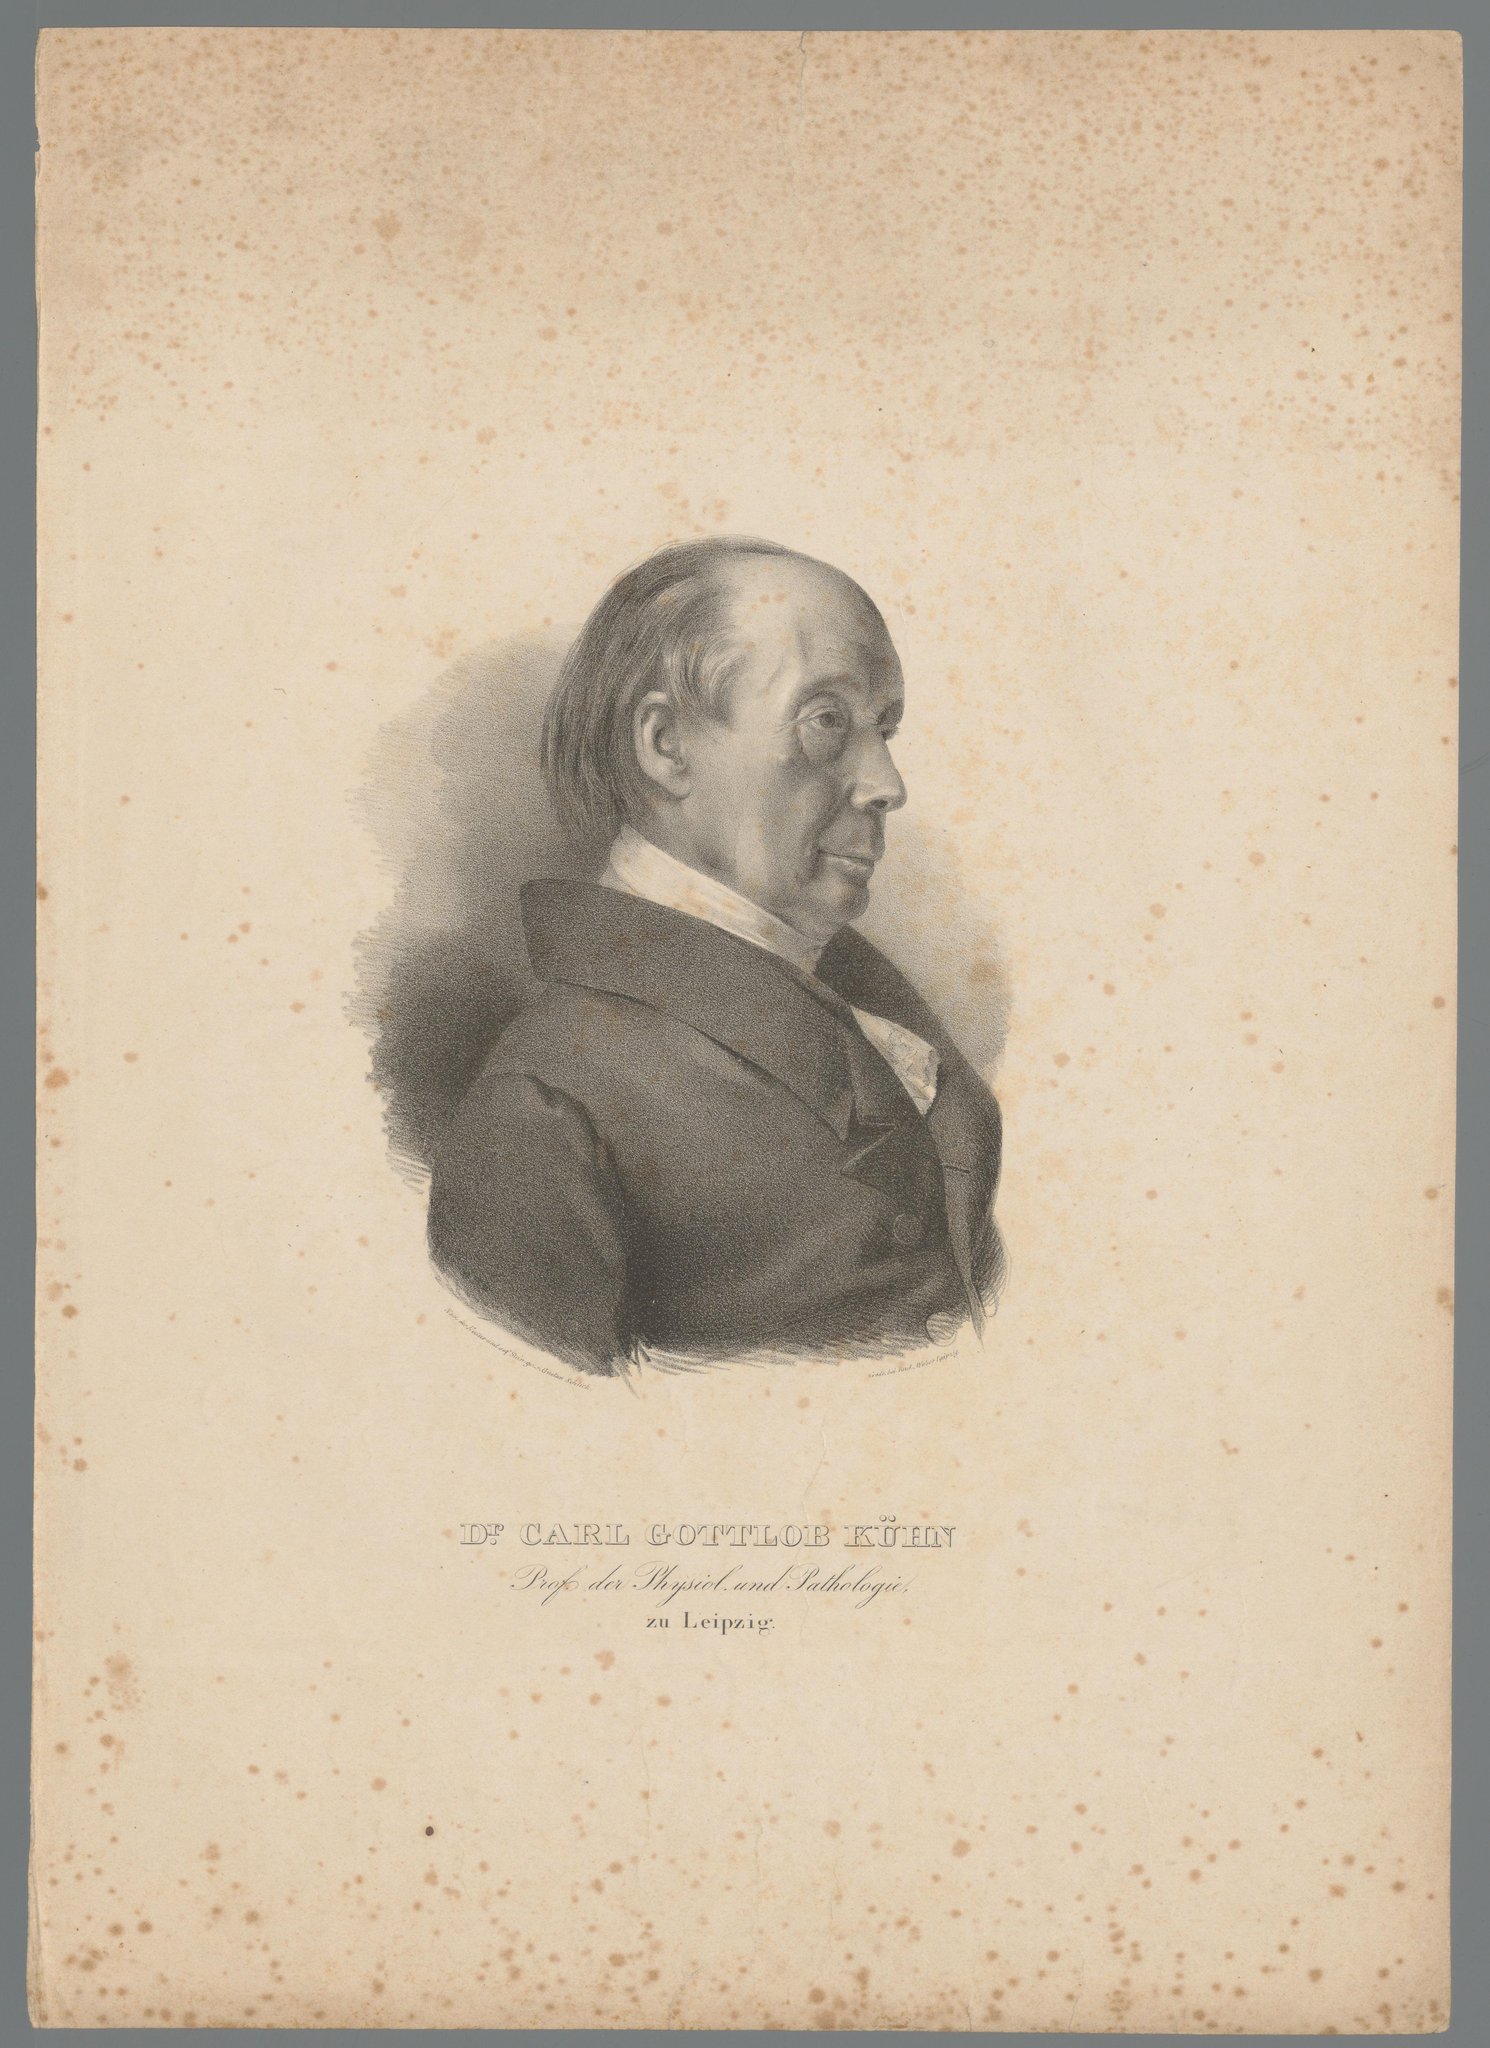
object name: print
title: Portret van Karl Gottlob Kühn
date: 1814-1869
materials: paper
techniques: lithograph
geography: leipzig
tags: historical persons, physician, doctor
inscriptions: collector's mark: Lugt 2228